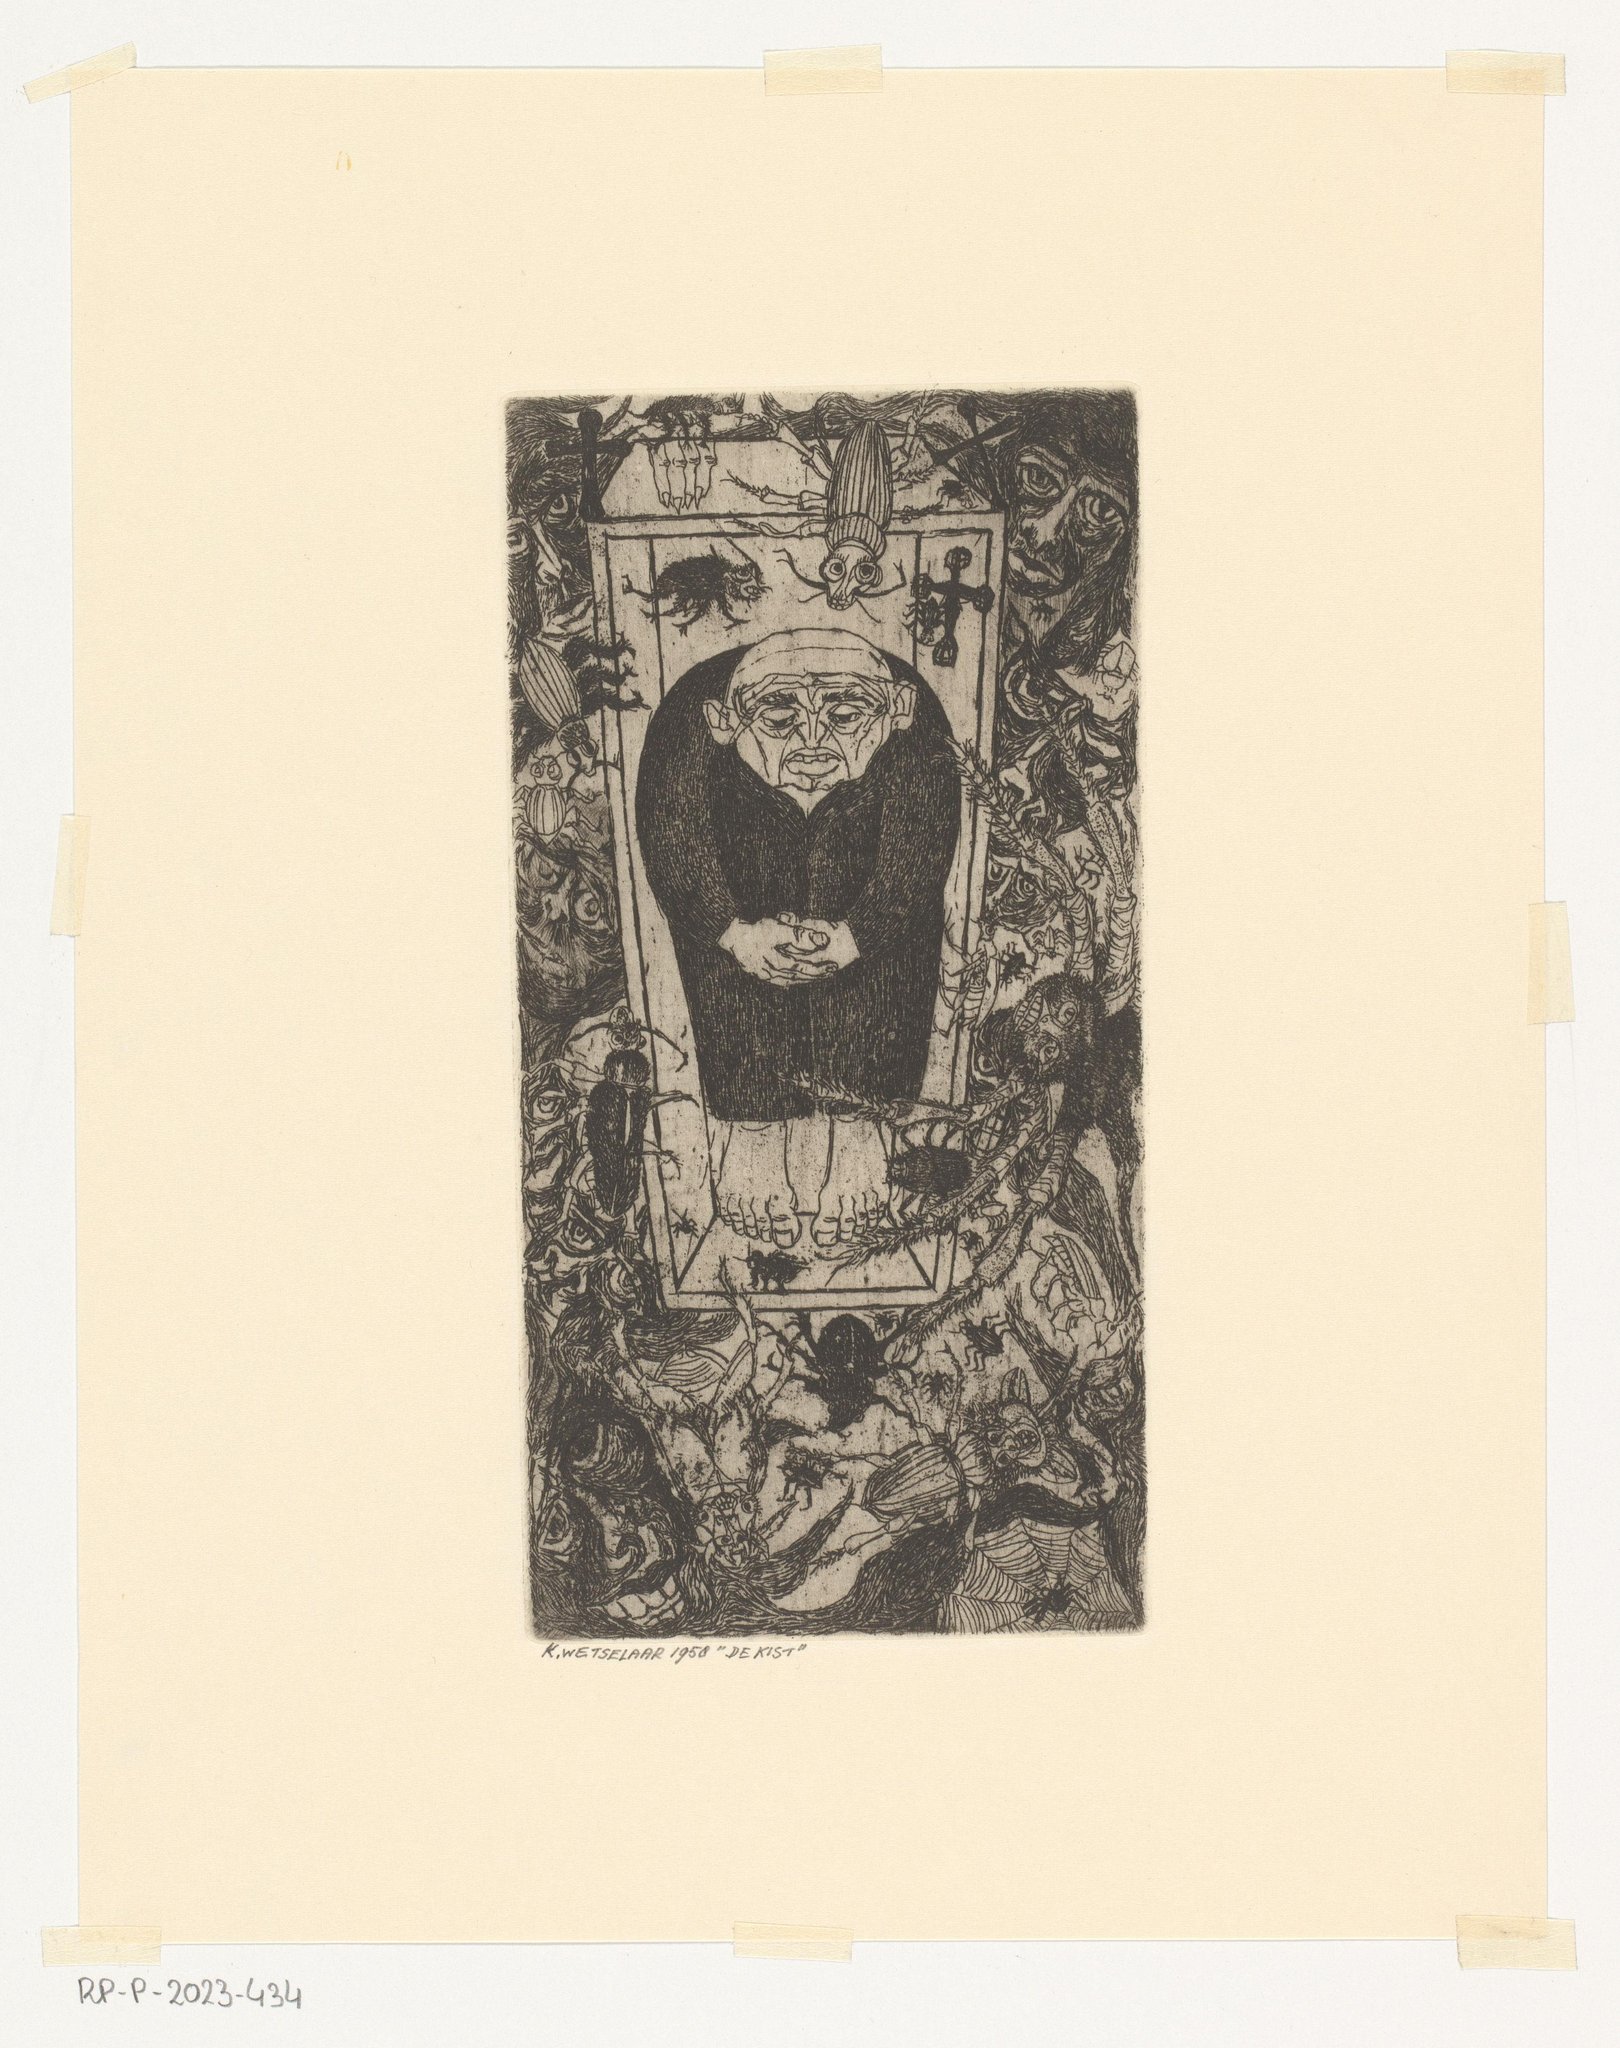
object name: print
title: De Kist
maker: karel wetselaar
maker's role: print maker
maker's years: 1935-2017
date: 1958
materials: paper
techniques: etching, intaglio, retroussage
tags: coffin, insects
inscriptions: signature and date: ‘K. Wetselaar 1958’